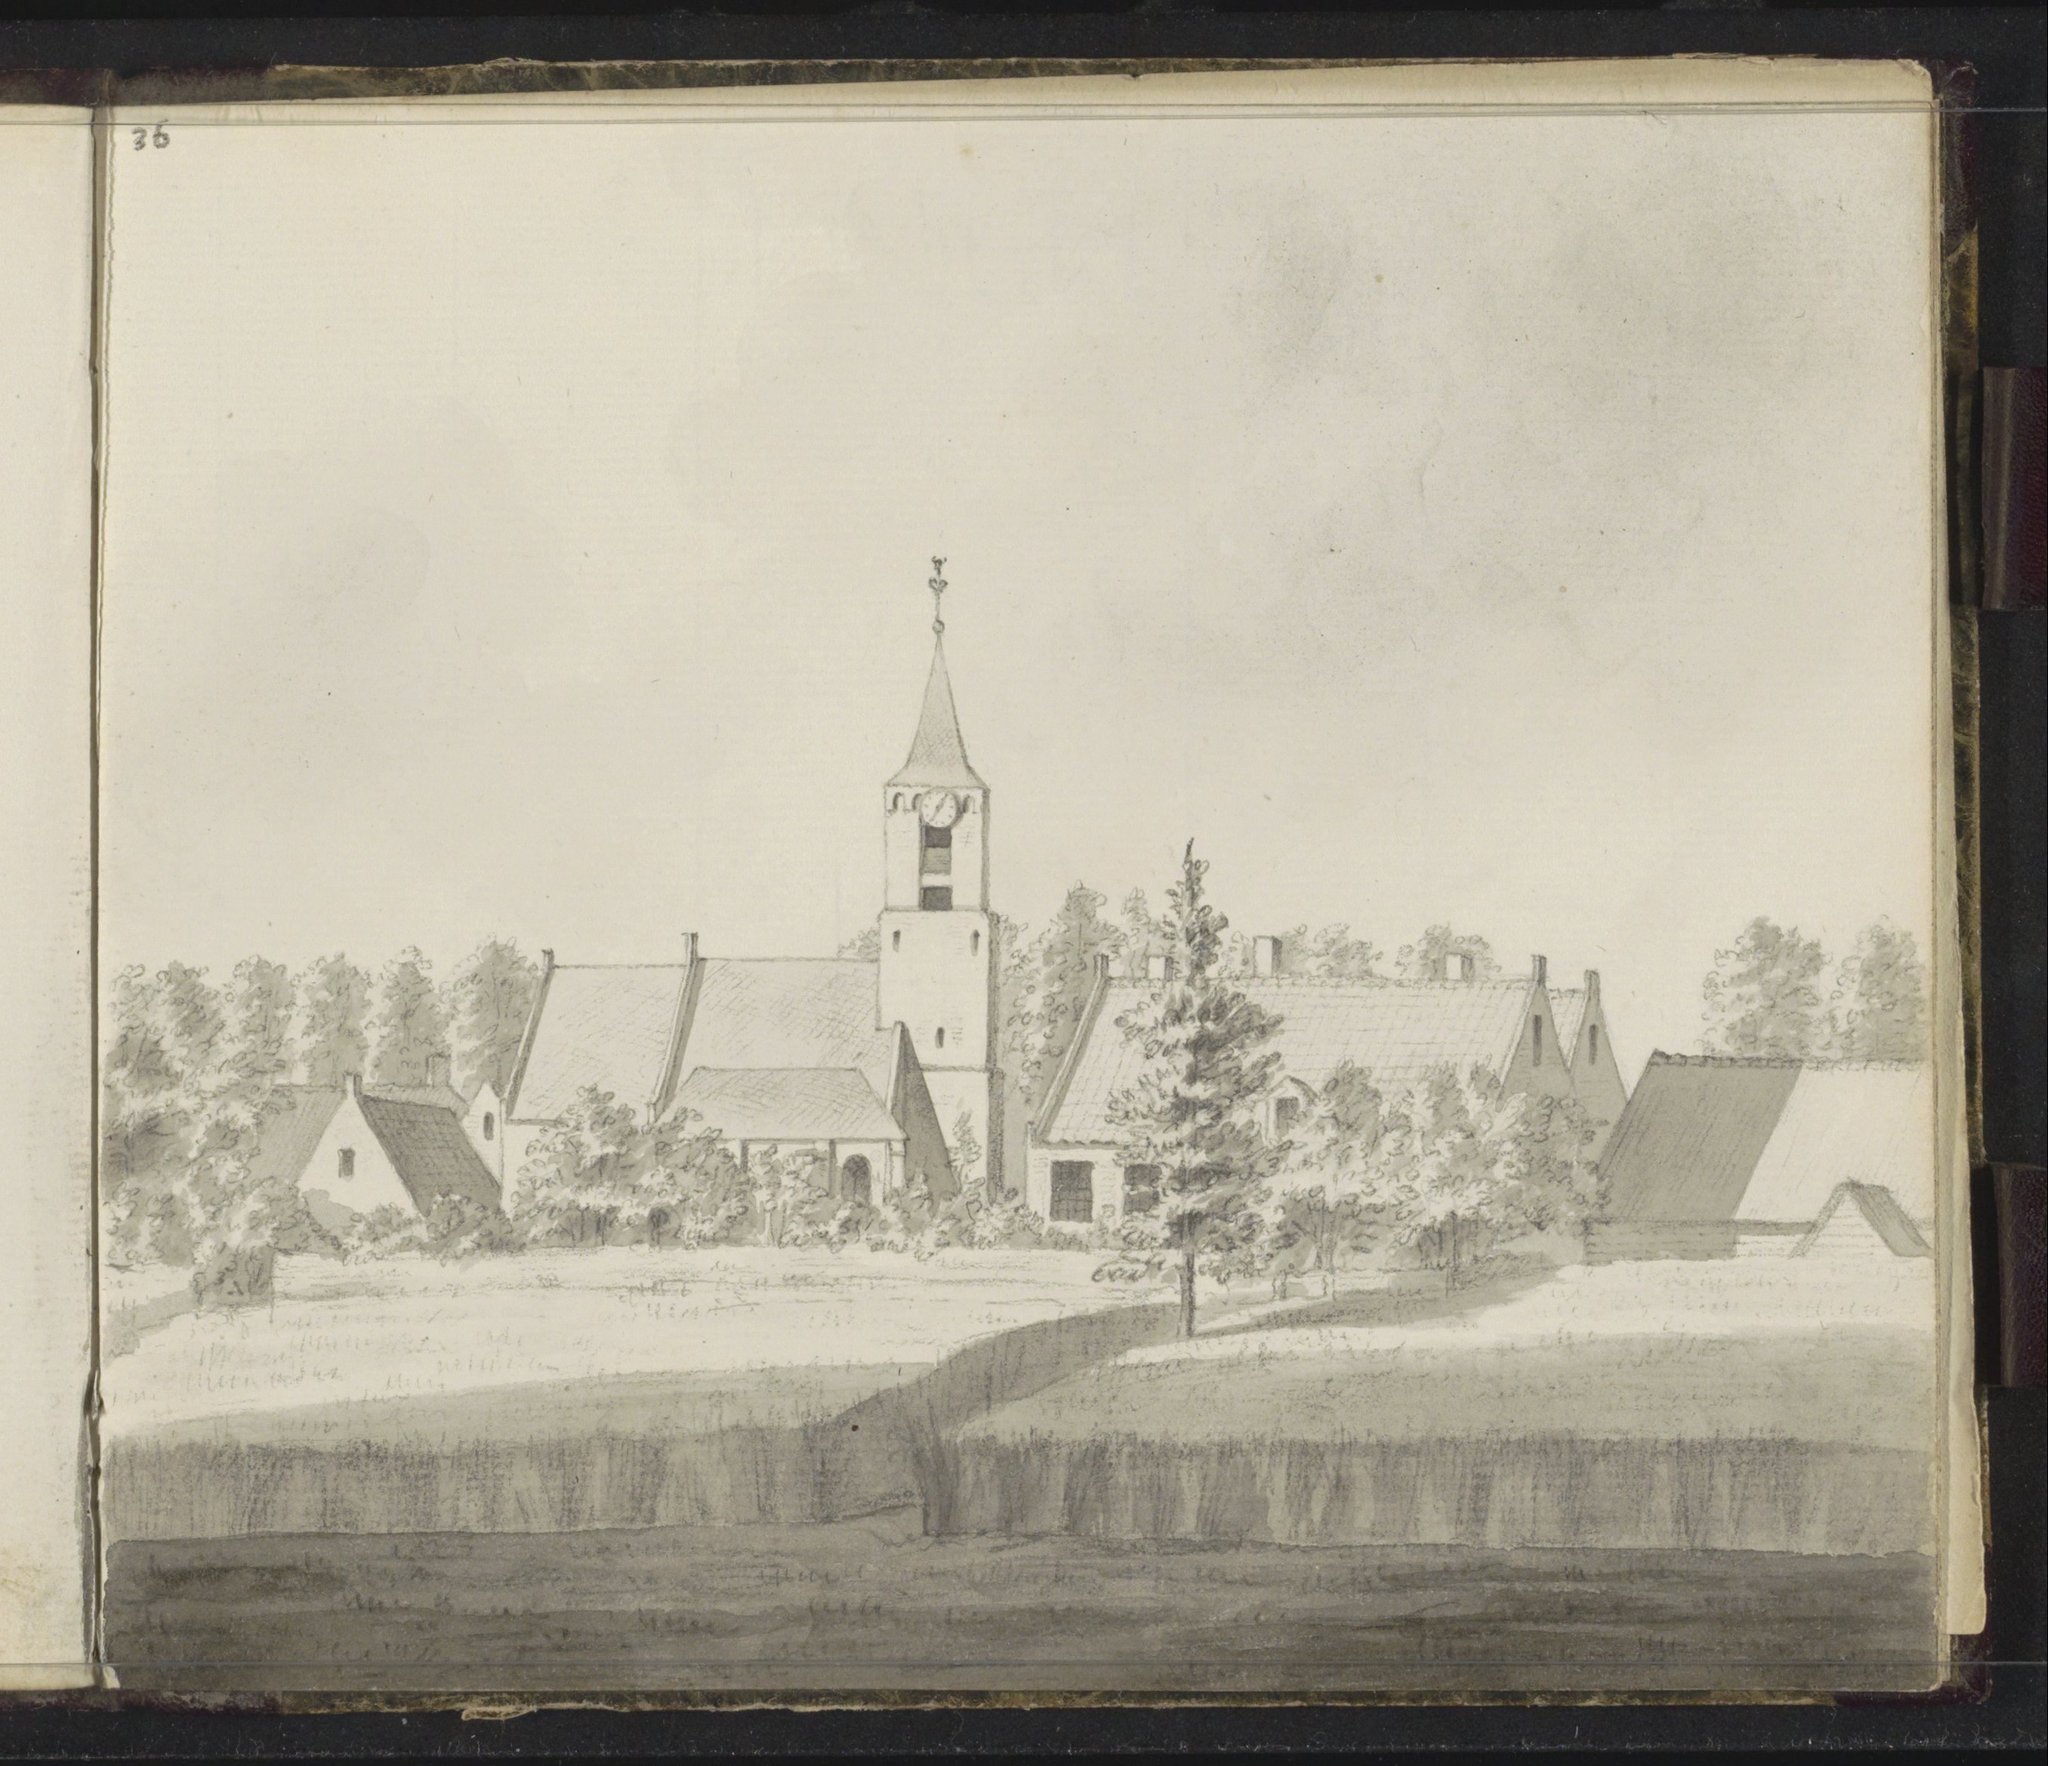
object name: sketchbook leaf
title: Dorpsgezicht met kerk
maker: hendrik abraham klinkhamer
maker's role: draughtsman, painter, print maker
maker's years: 1810-1872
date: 1820-1872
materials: chalk, paper, watercolor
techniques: brush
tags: village, church (exterior)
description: Blad 36 recto uit een schetsboek met 39 bladen.